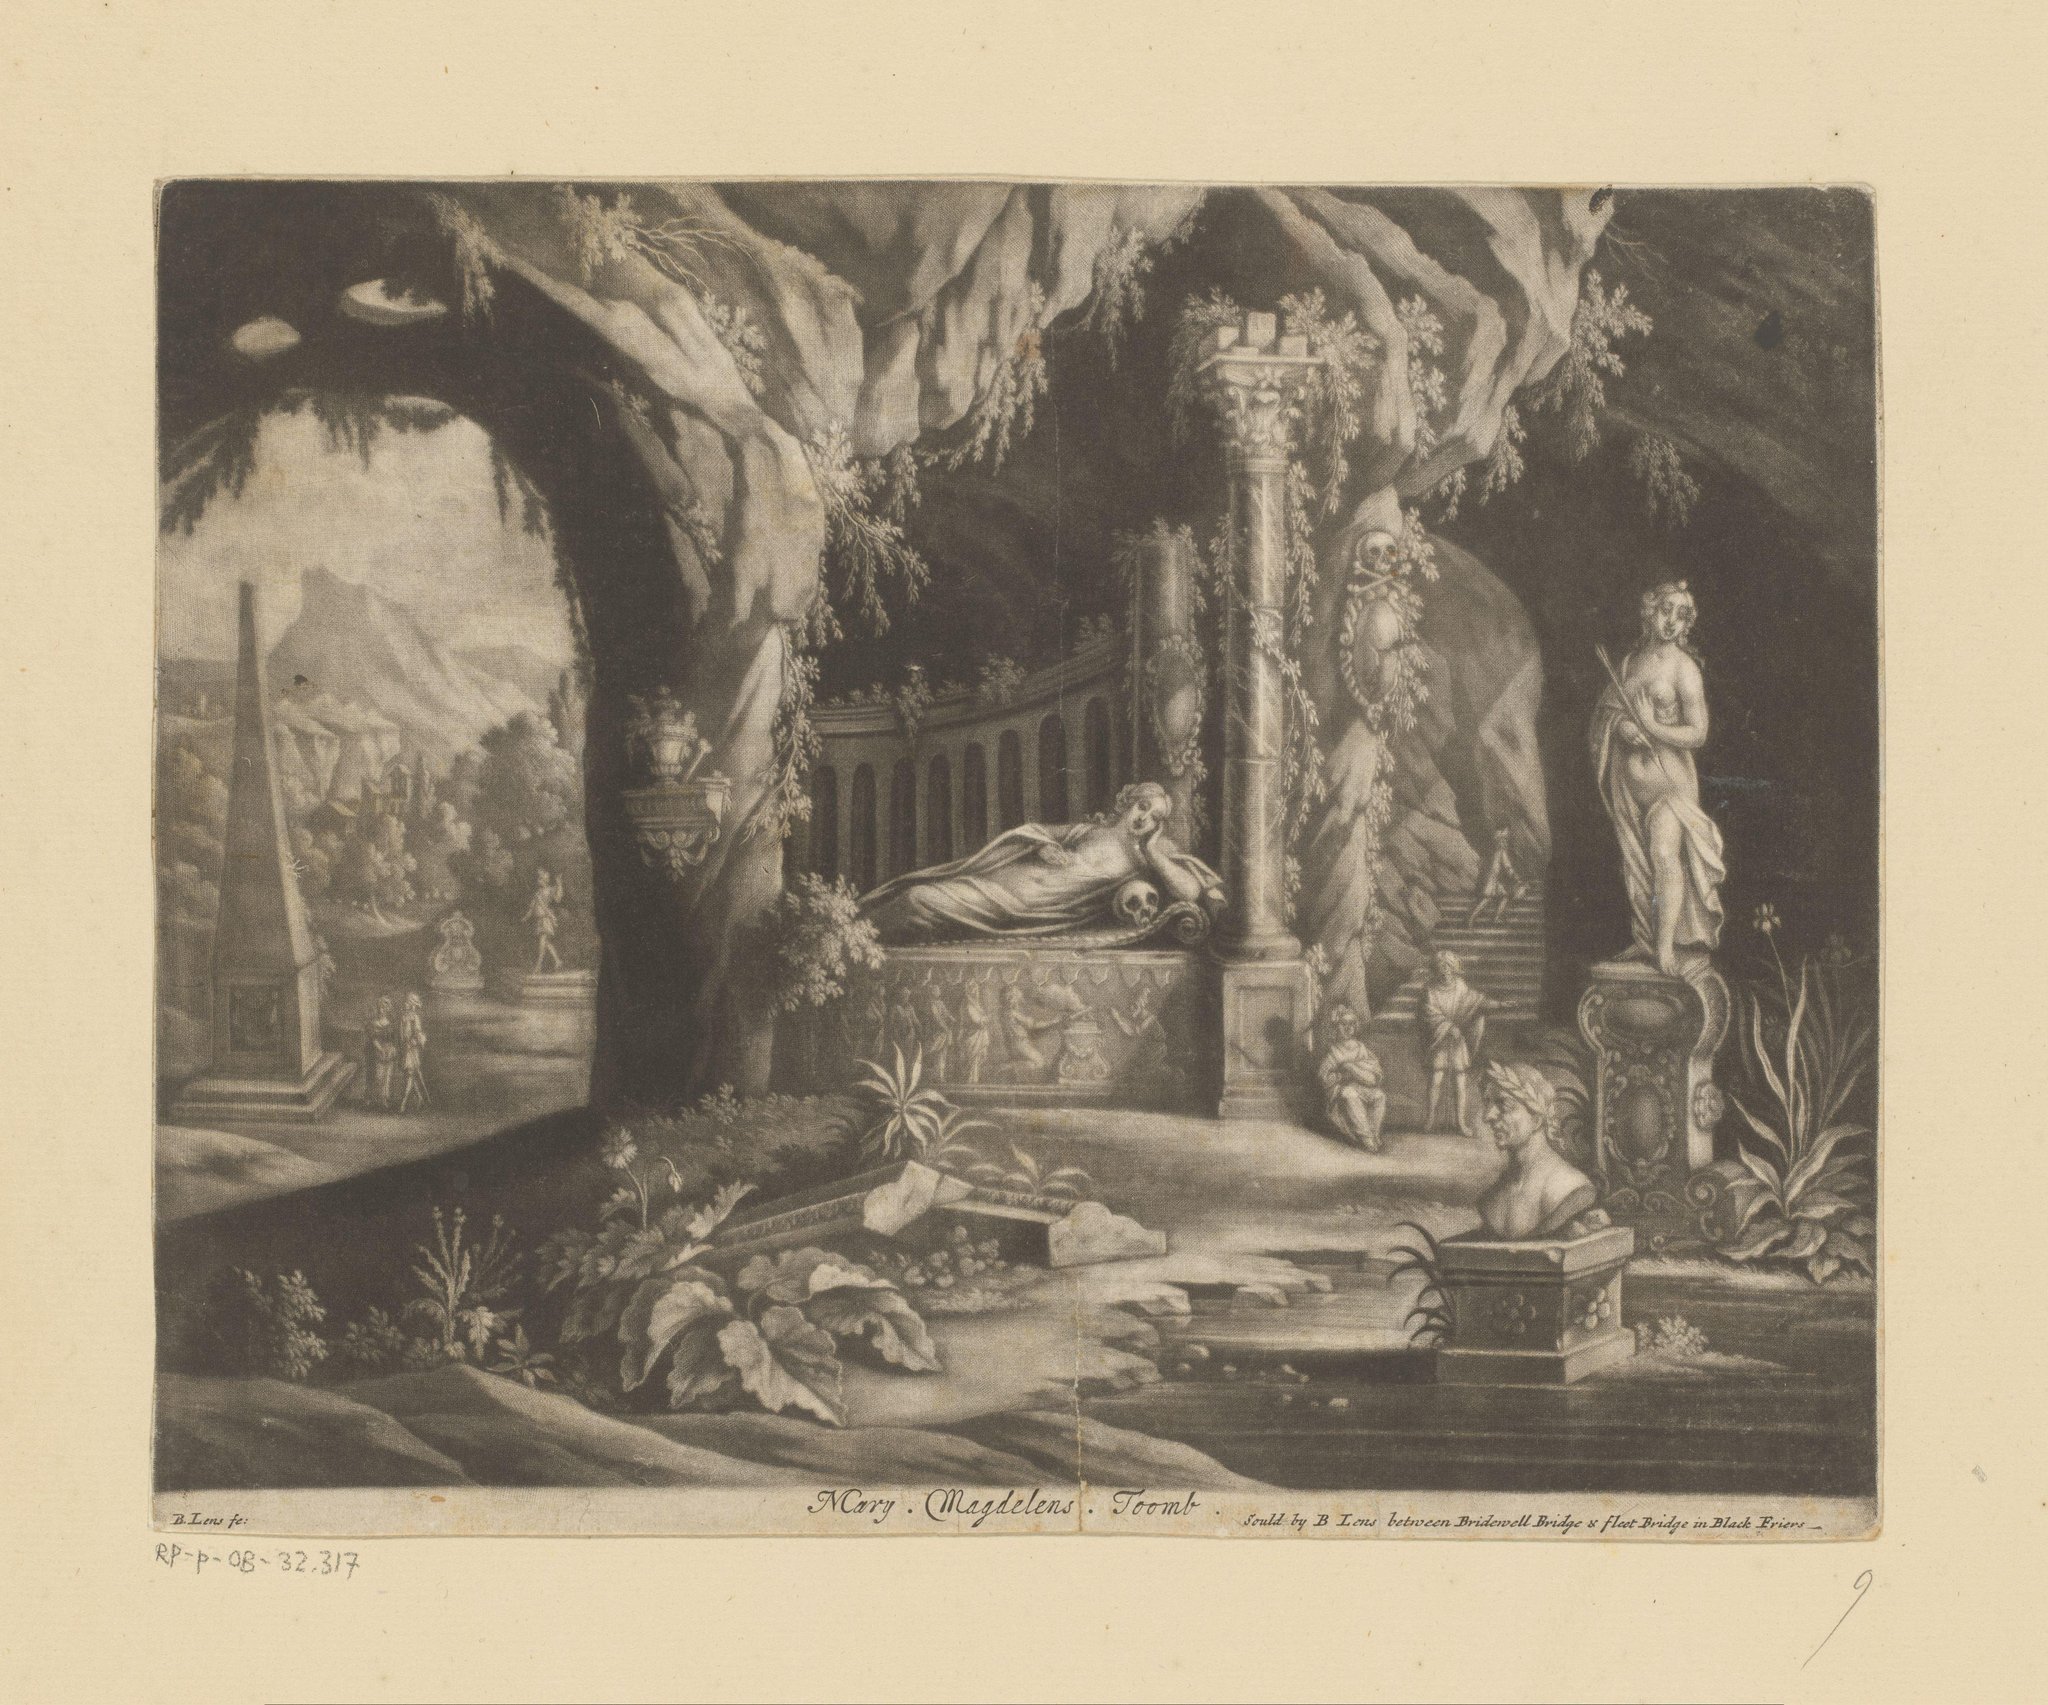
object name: print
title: Mary Magdelens Toomb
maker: bernard lens (ii)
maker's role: print maker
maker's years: 1659-1725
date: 1669-1725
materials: paper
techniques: mezzotint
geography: london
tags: grave, tomb, the penitent harlot mary magdalene; possible attributes: book (or scroll), crown, crown of thorns, crucifix, jar of ointment, mirror, musical instrument, palm-branch, rosary, scourge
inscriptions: collector's mark: Lugt 240